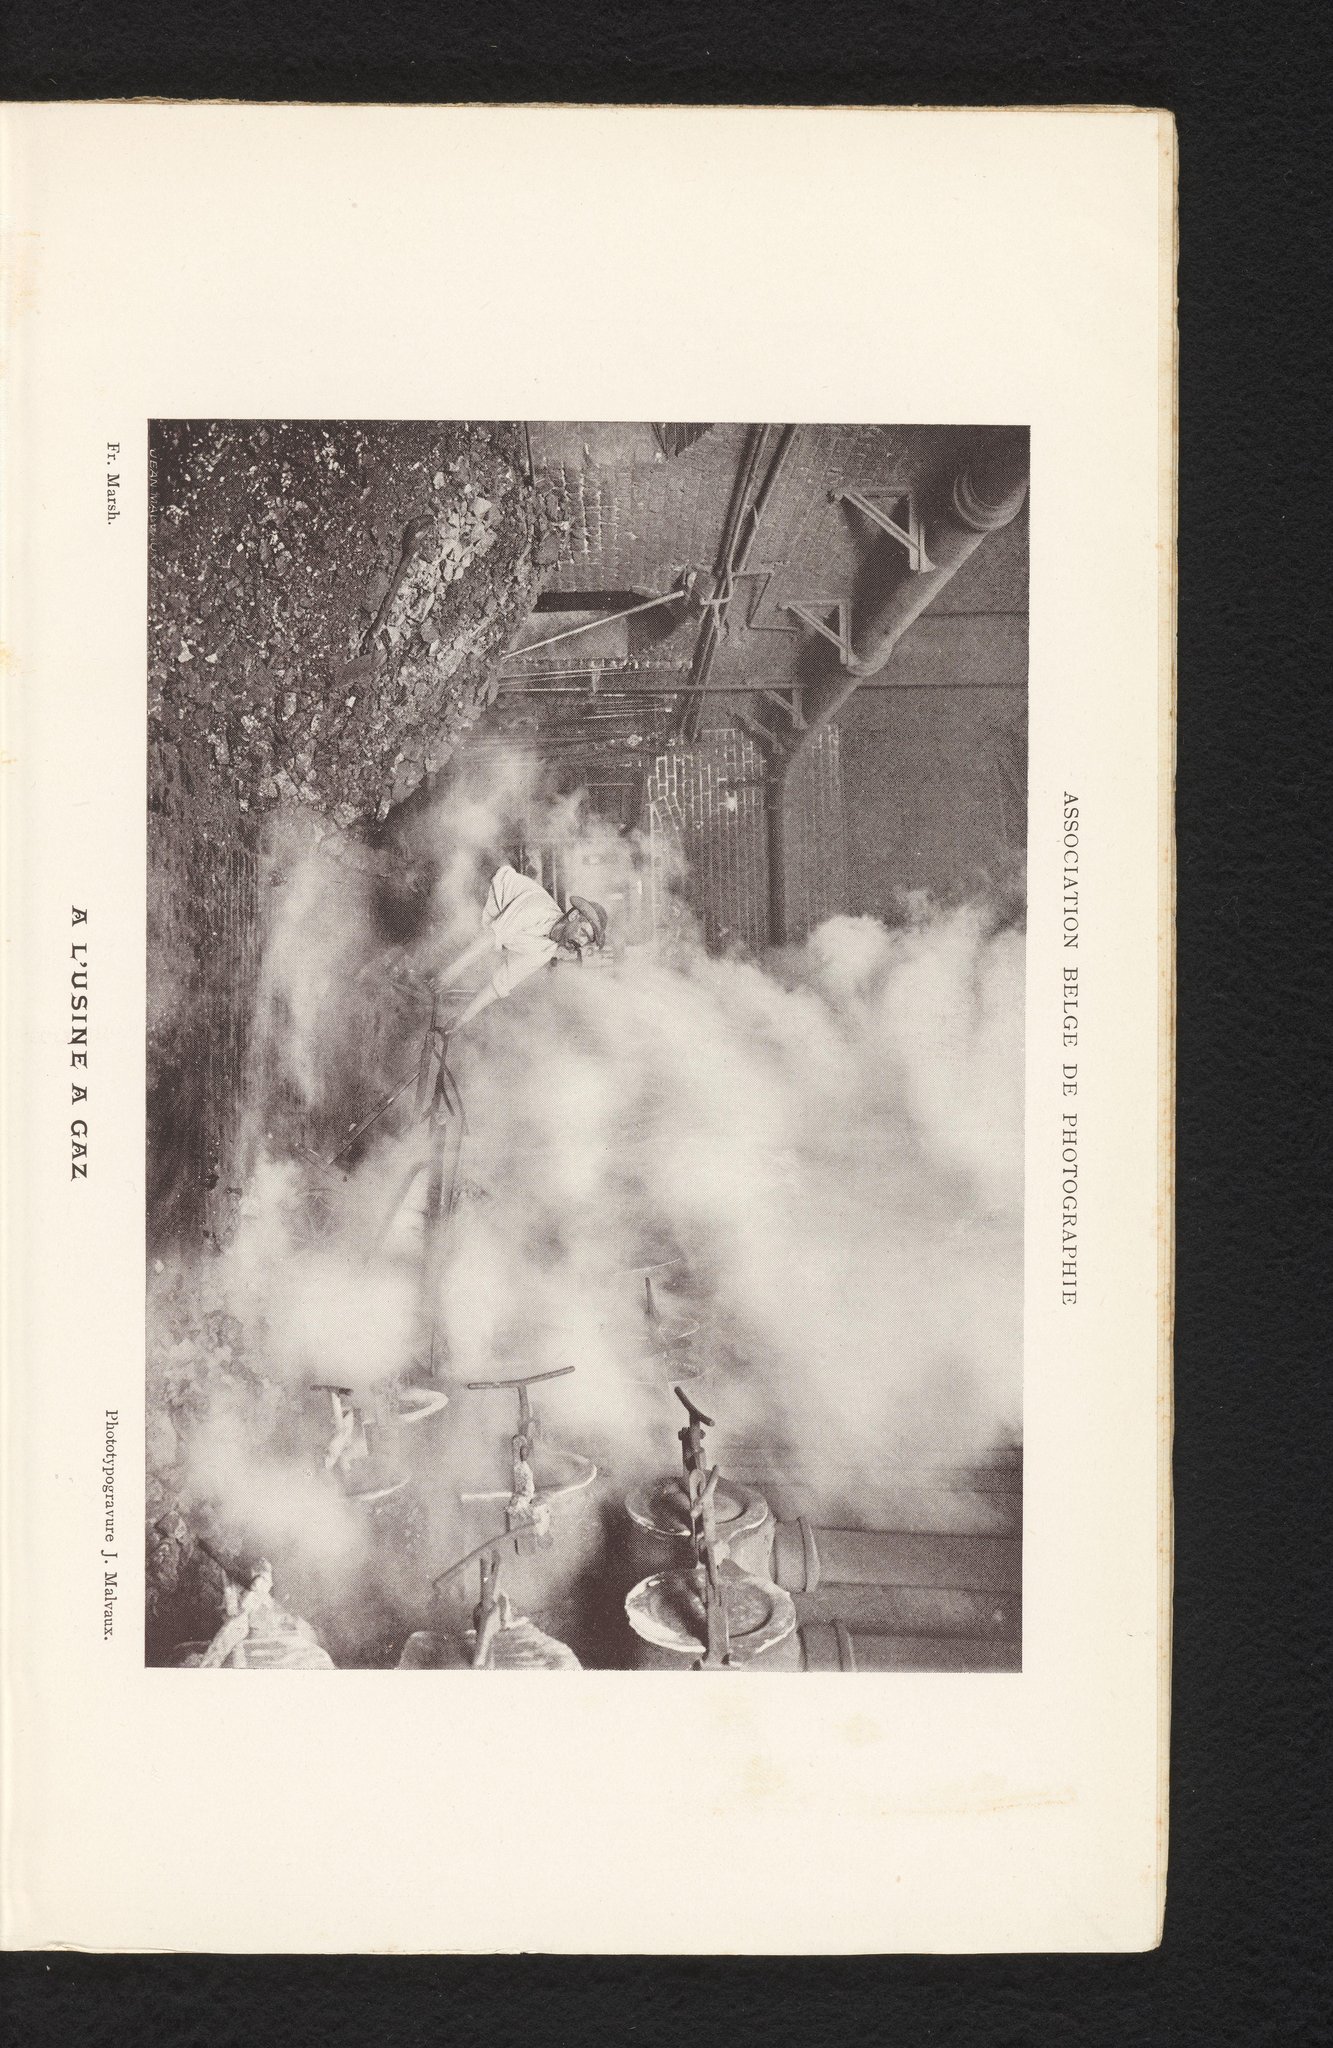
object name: photomechanical print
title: In een gasinstallatie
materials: paper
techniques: autotype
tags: gasworks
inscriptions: inscription: ‘ASSOCIATION BELGE DE PHOTOGRAPHIE’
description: Prent op derde ongenummerde pagina na pagina XIV.